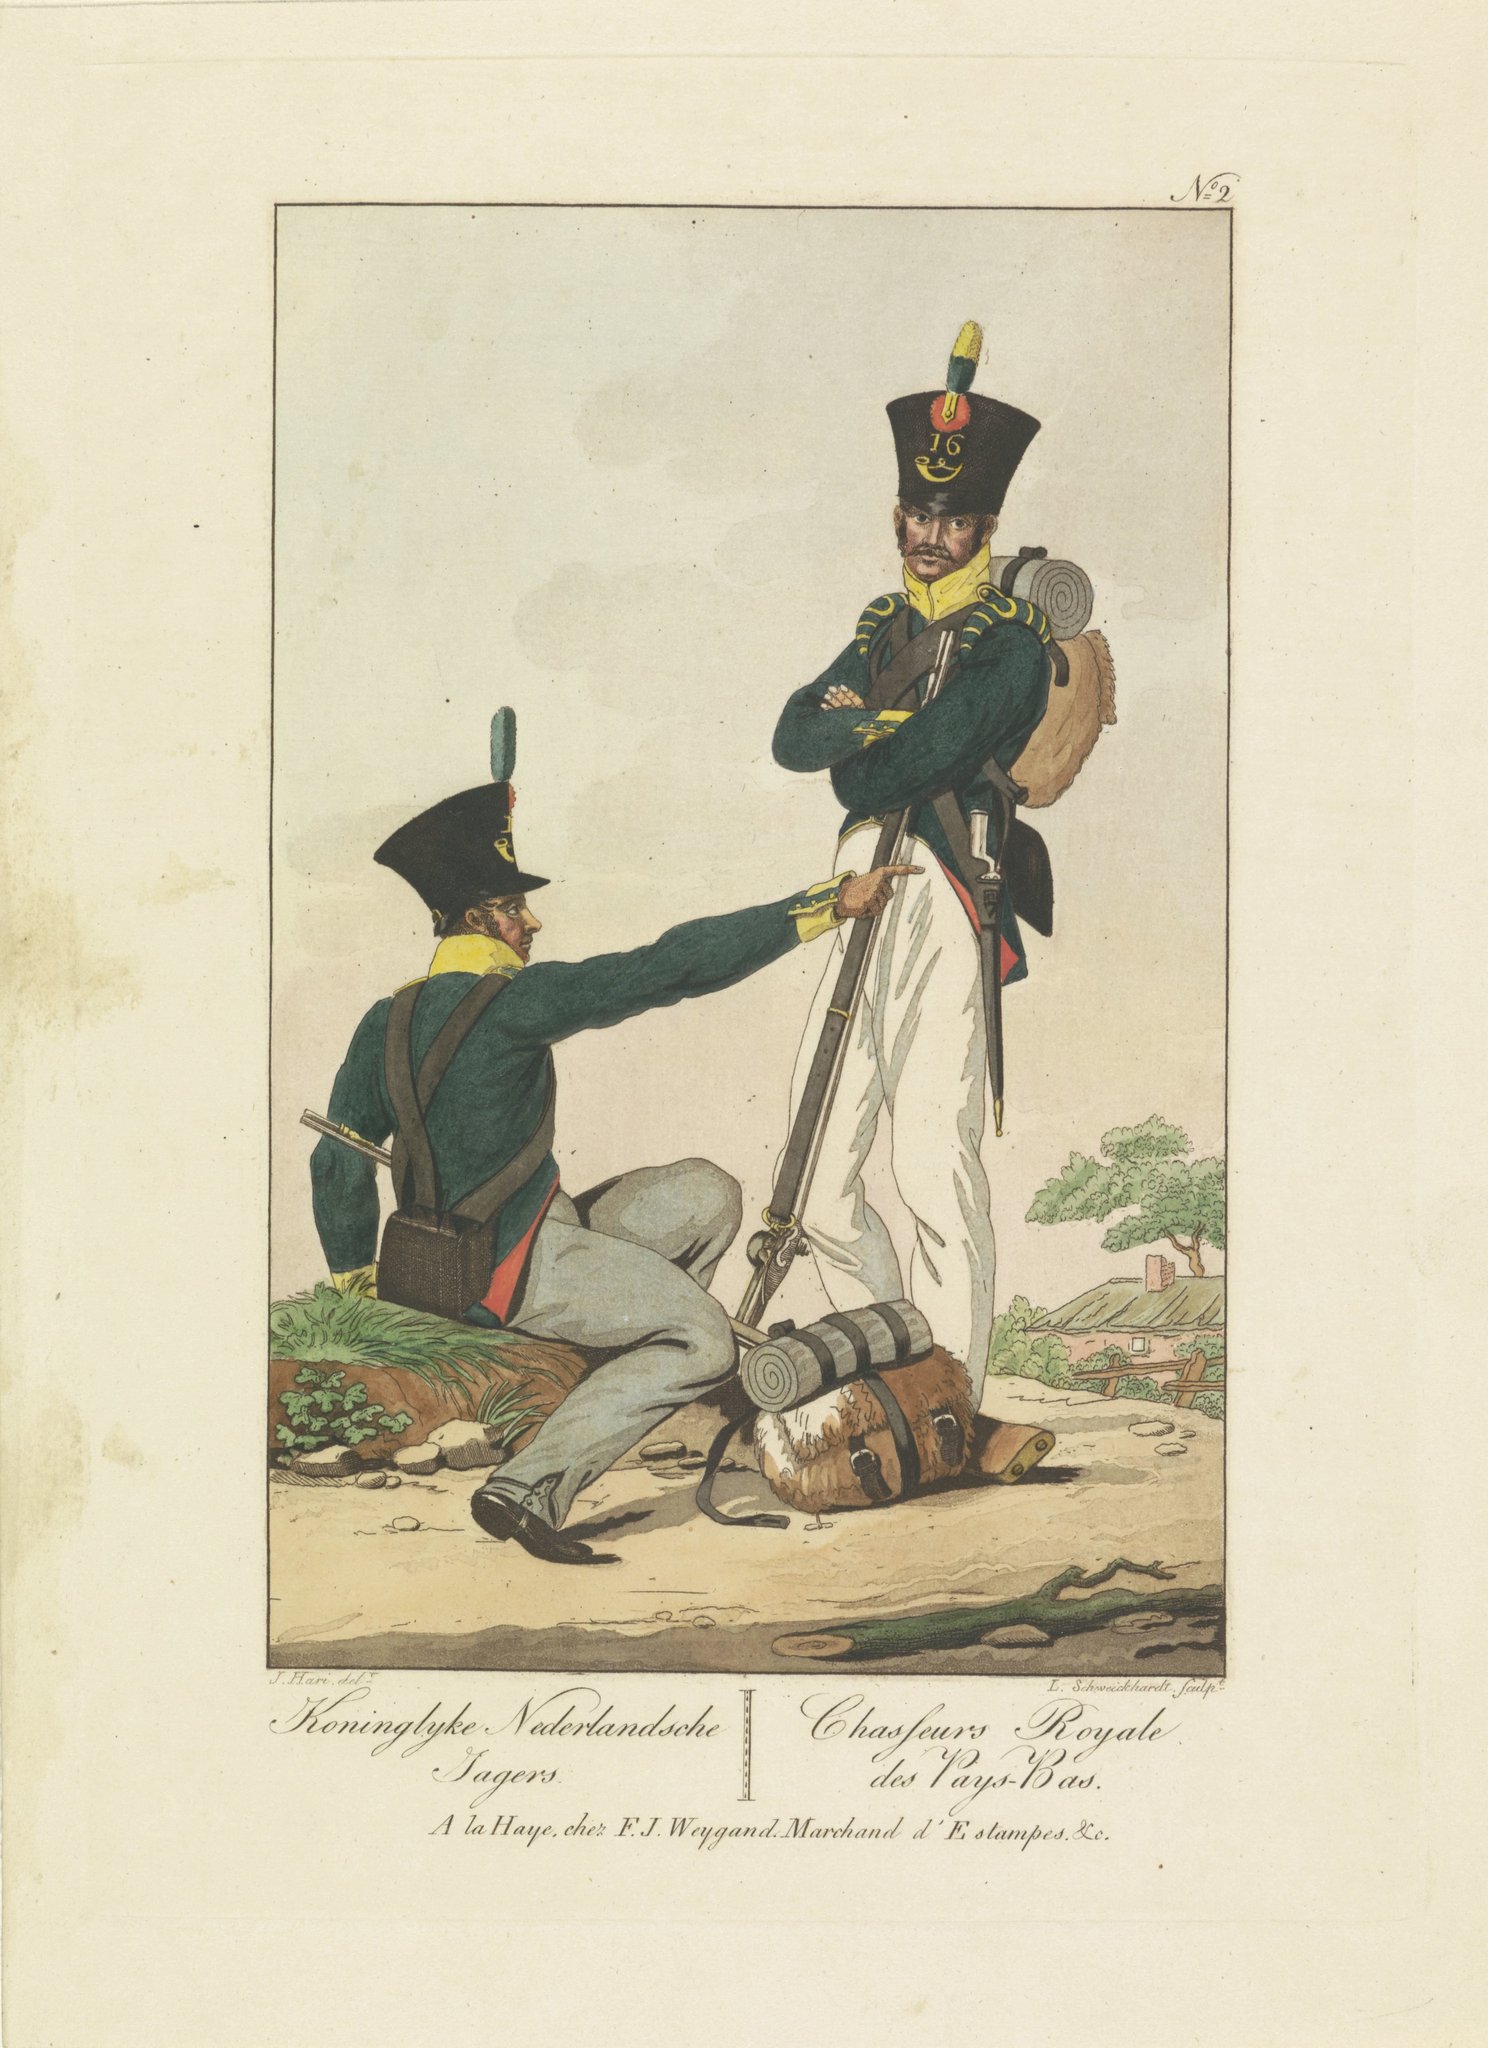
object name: print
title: Zeven uniformvoorstellingen 1814-1818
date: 1814-1818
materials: paper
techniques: aquatint, etching, hand coloring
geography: netherlands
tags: (military) uniforms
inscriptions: inscription: ‘WE:’, collector's mark: Lugt 2228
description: Uniformvoorstelling van twee militairen van het 16e regiment jagers van de infanterie. Genummerd rechtsboven: Pl. 2. Onderdeel van een reeks van zeven platen van uniformen van de militairen van het Koninkrijk der Nederlanden in de periode 1814-1818.